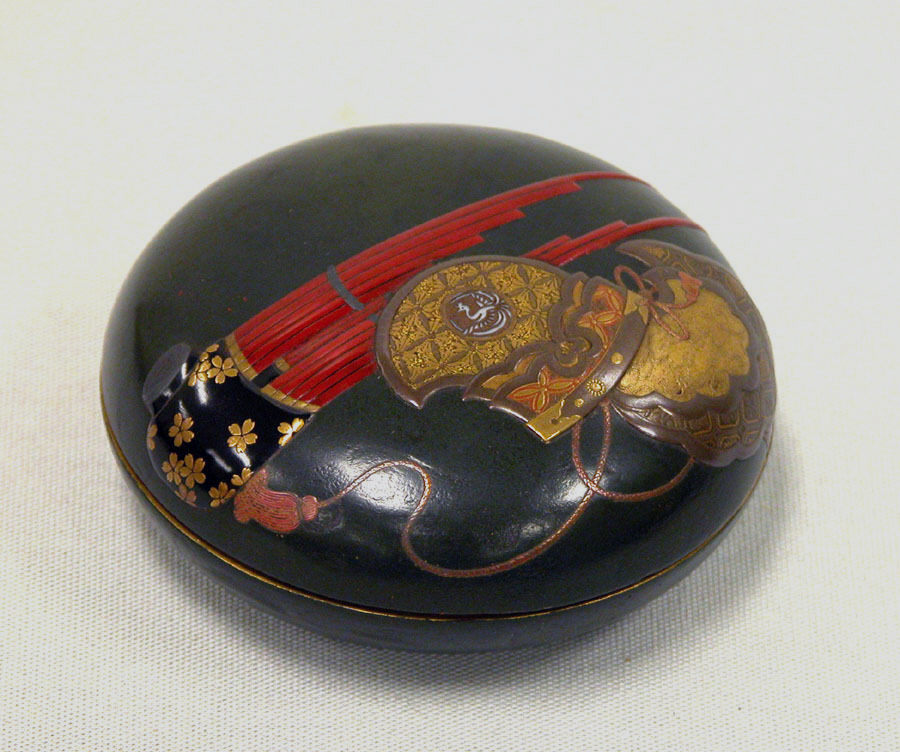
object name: round box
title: Round Box with Design of Bugaku Dance Hat and Musical Instrument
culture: japanese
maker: yamada jōkasai (1681–1704)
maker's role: artist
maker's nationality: japanese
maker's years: 1681-1704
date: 1801-1900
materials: gold, lacquer, mother of pearl, wood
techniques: inlay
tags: musical instruments,hats